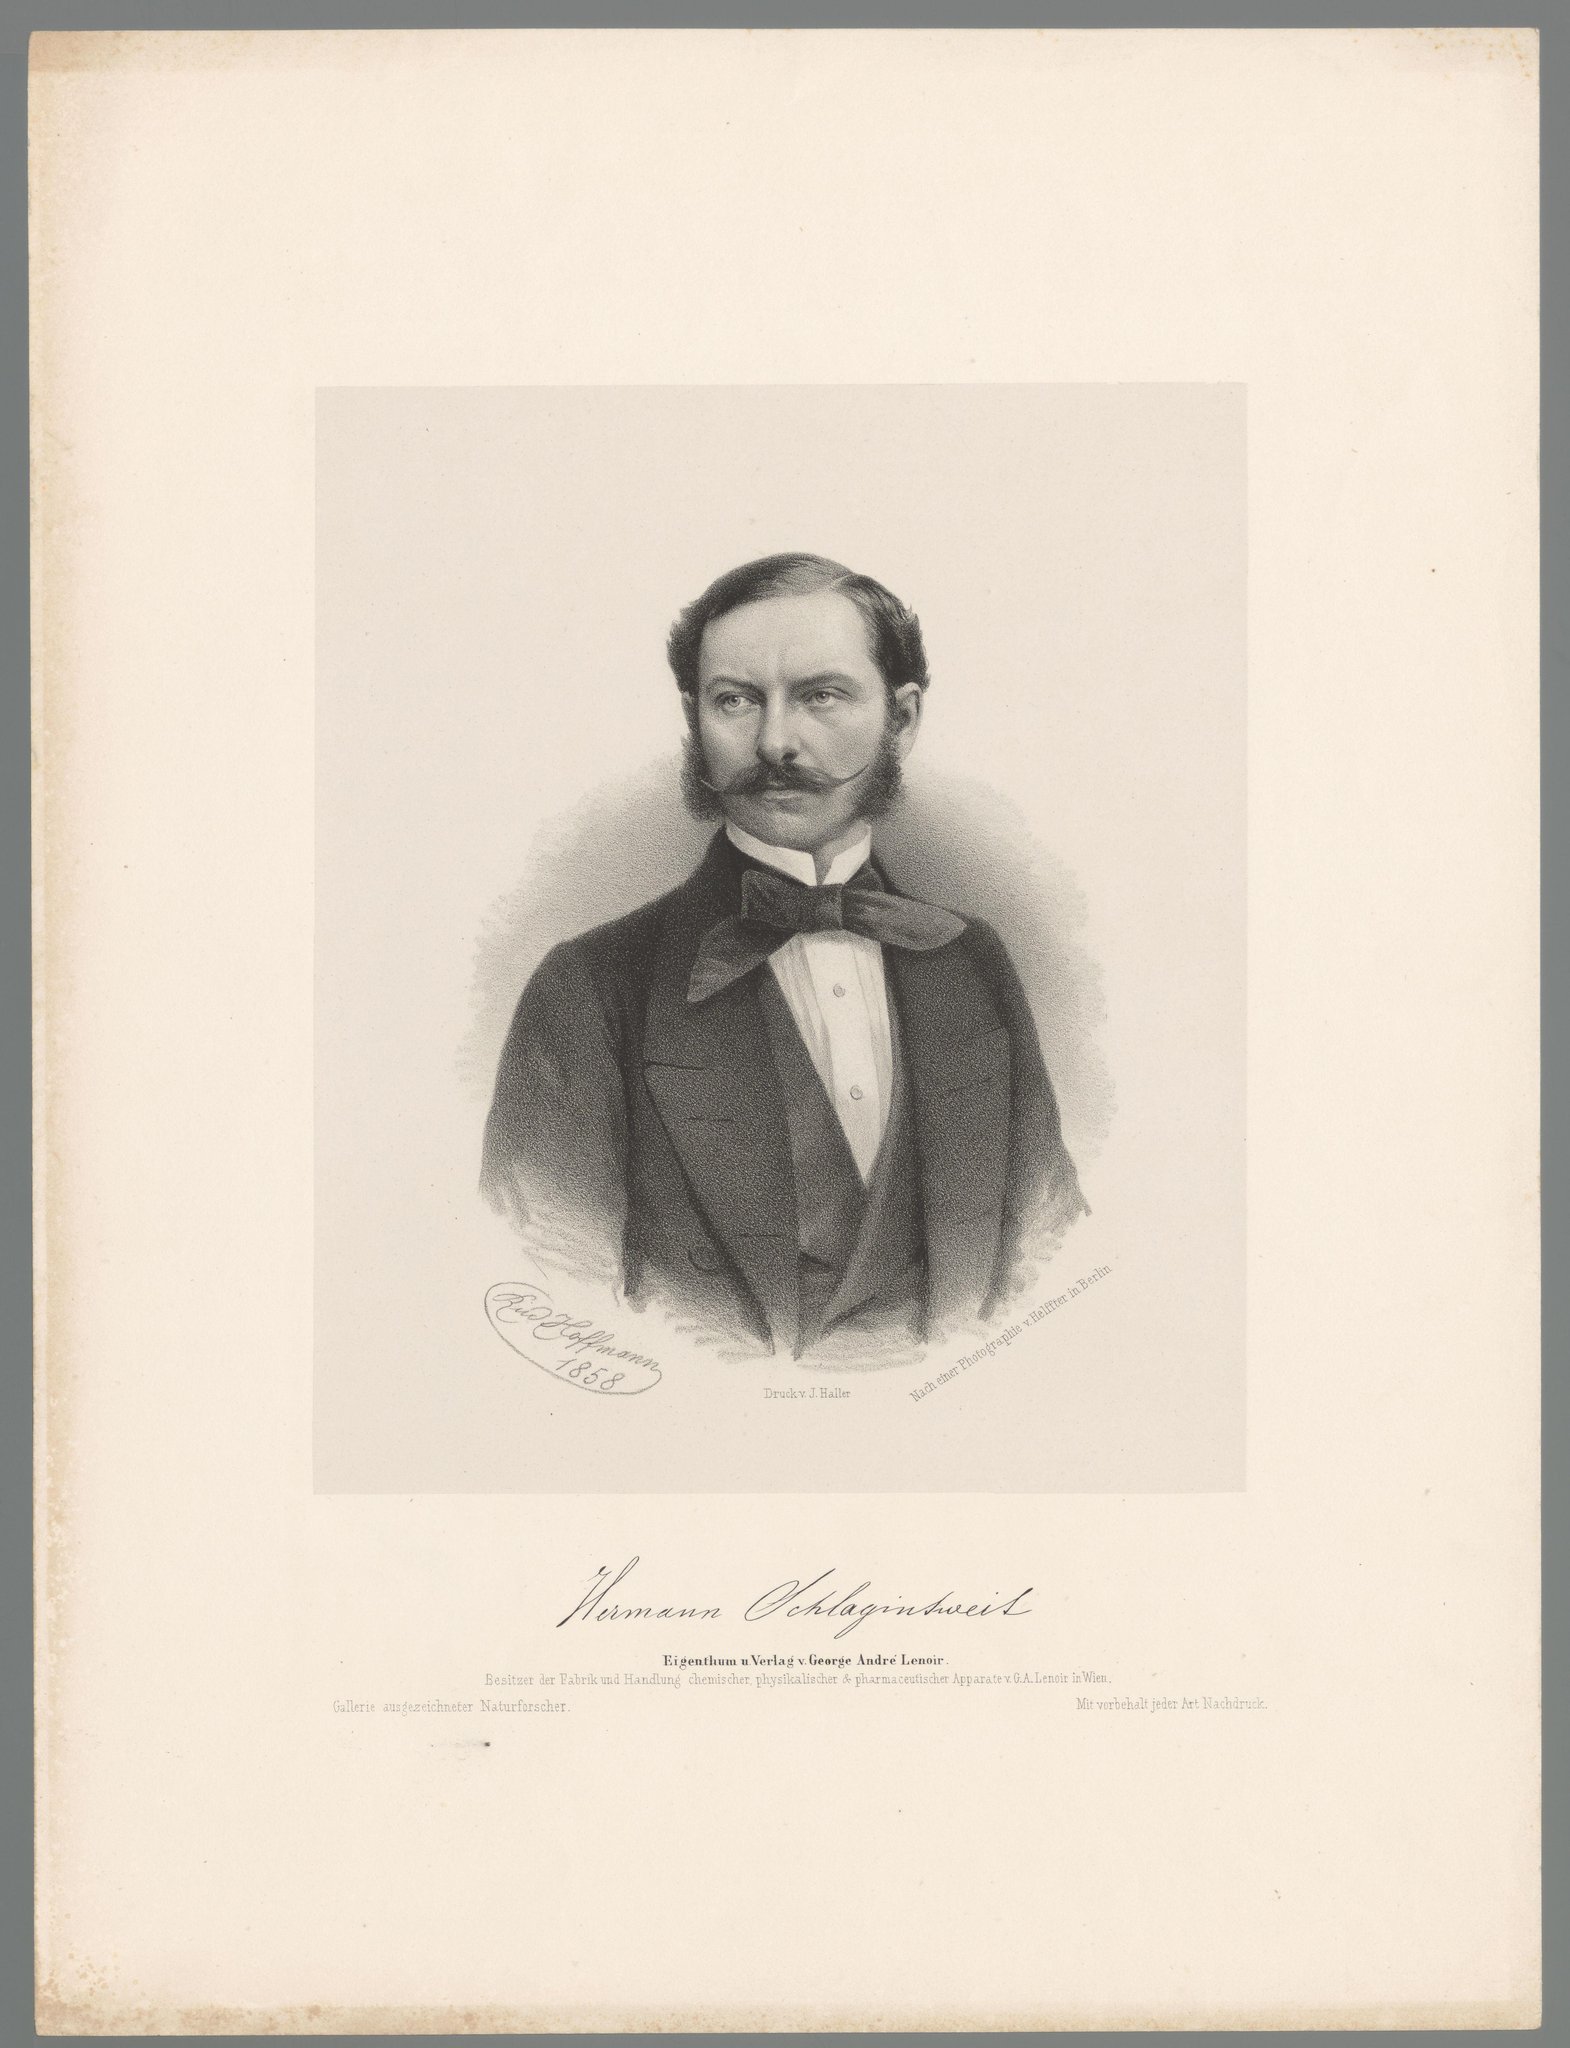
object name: print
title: Portret van Hermann Schlagintweit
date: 1858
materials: paper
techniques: lithograph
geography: berlin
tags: moustache, adult man, historical persons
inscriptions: collector's mark: Lugt 2228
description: Deze prent behoort tot een serie met 100 portretten van natuurwetenschappers, uitgegeven tussen 1856-1860.